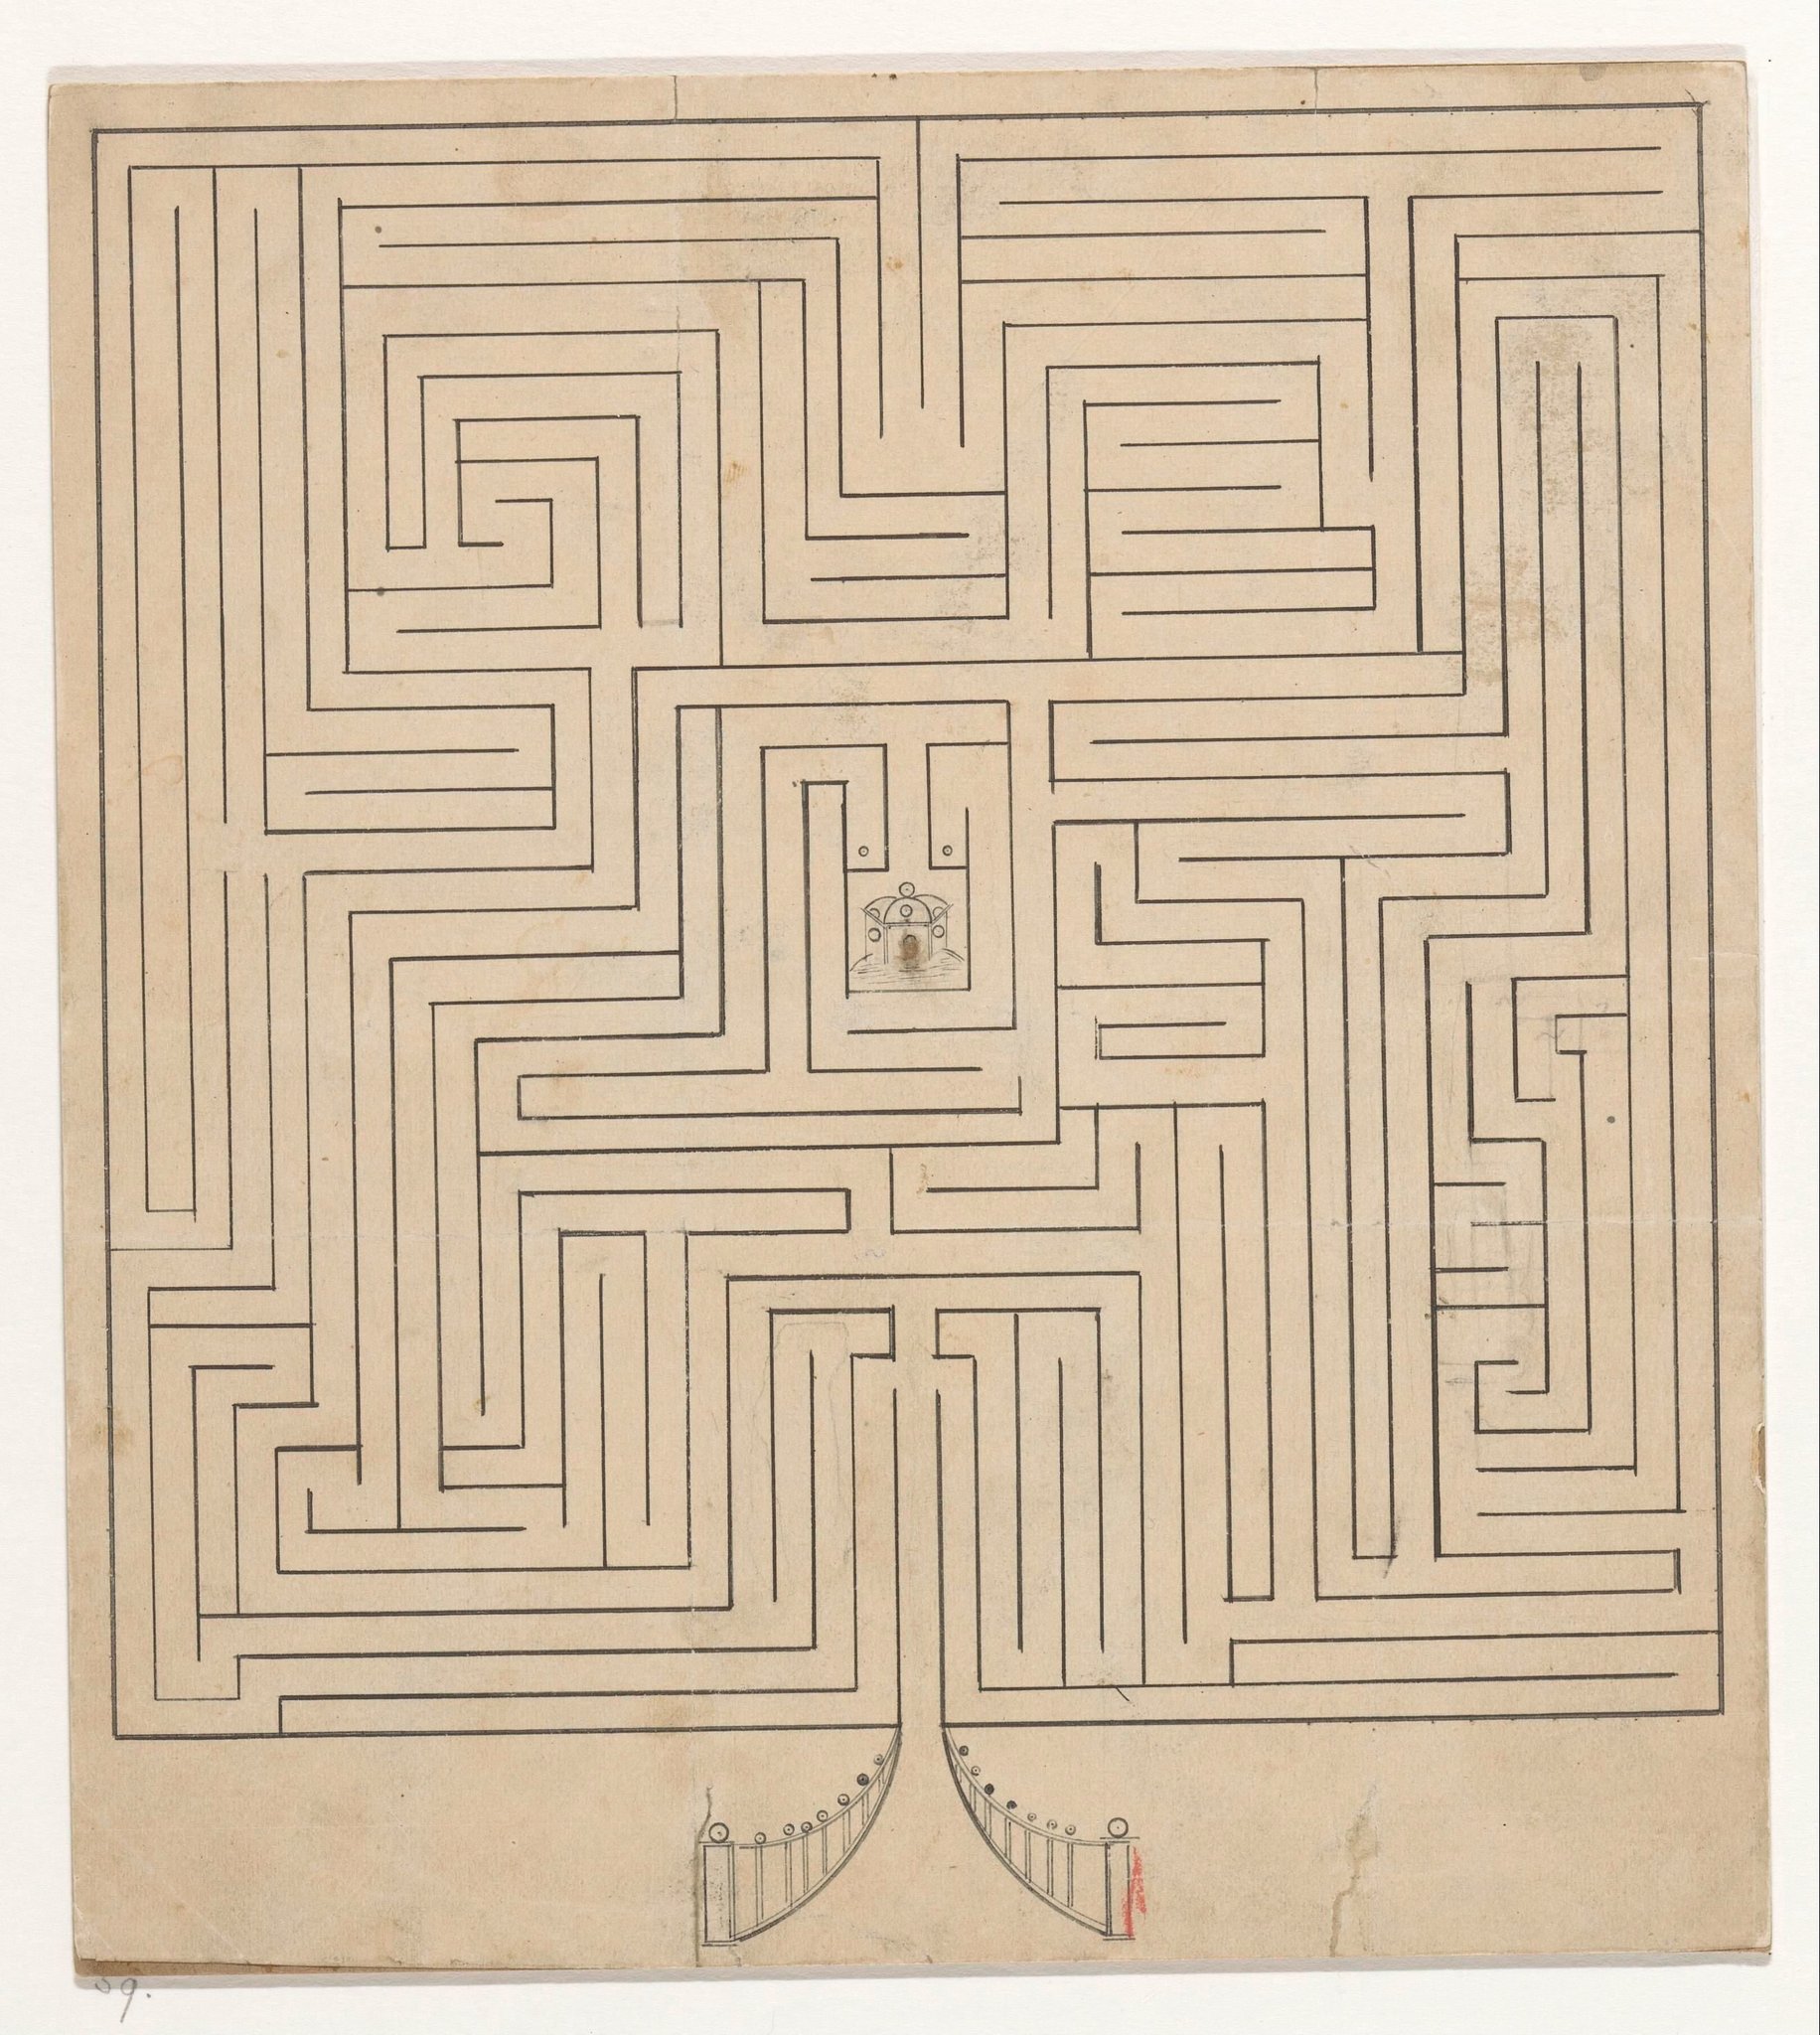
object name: drawing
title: Labyrint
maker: jan brandes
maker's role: draughtsman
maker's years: 1743-1808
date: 1770-1808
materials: cardboard, ink, paper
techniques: pen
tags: labyrinth, maze ~ garden, board-games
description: Vierkant doolhof met in het midden de schat en bij de ingang een hekje.